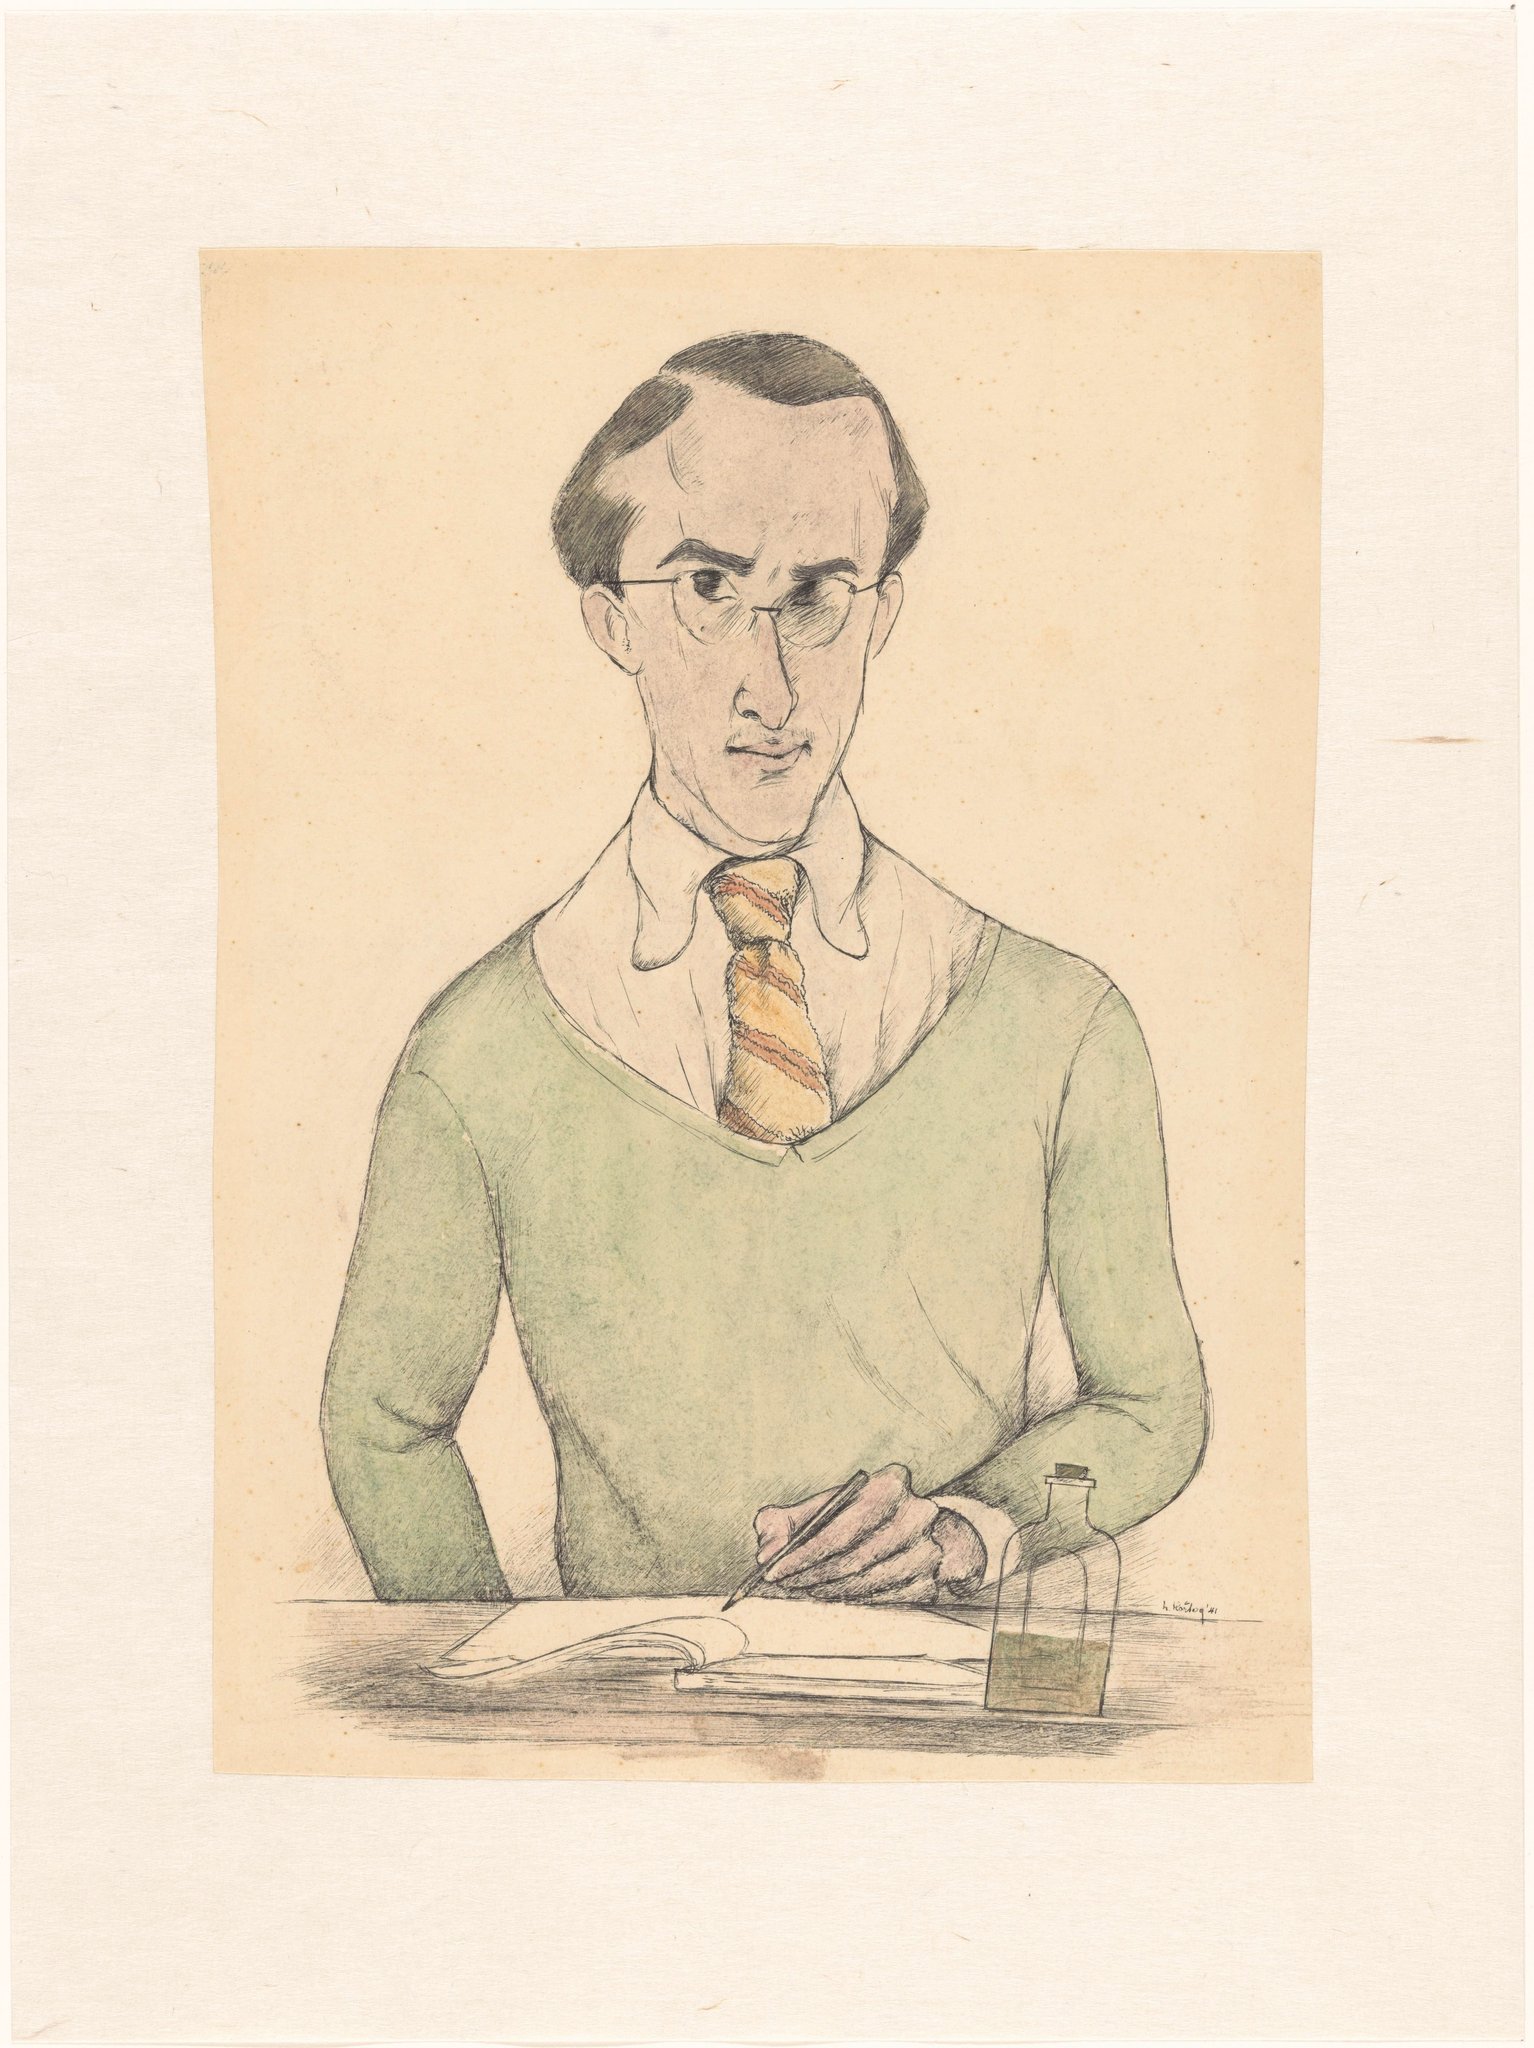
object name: print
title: Self-portrait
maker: henk hartog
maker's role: draughtsman, print maker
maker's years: 1915-1942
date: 1941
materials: ink, paper, watercolor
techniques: brush, etching, hand coloring, pen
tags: print maker, draughtsman, henk hartog, draughtsman at work, portrait, self-portrait of artist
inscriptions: inscription: ‘Paul Citroen Oostdorperweg Wassenaar’, collector's mark: Lugt 2228, collector's mark: Lugt 2760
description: Hartog was trained as a graphic artist and draughtsman in The Hague and London. In 1938 he left for the United States, but in spite of his Jewish origins and the political tensions in Europe, he returned to the Netherlands a year later. In 1942, facing persecution from the Nazi regime, he fled by train to Switzerland, but was arrested during this journey and put on a transport to Auschwitz.